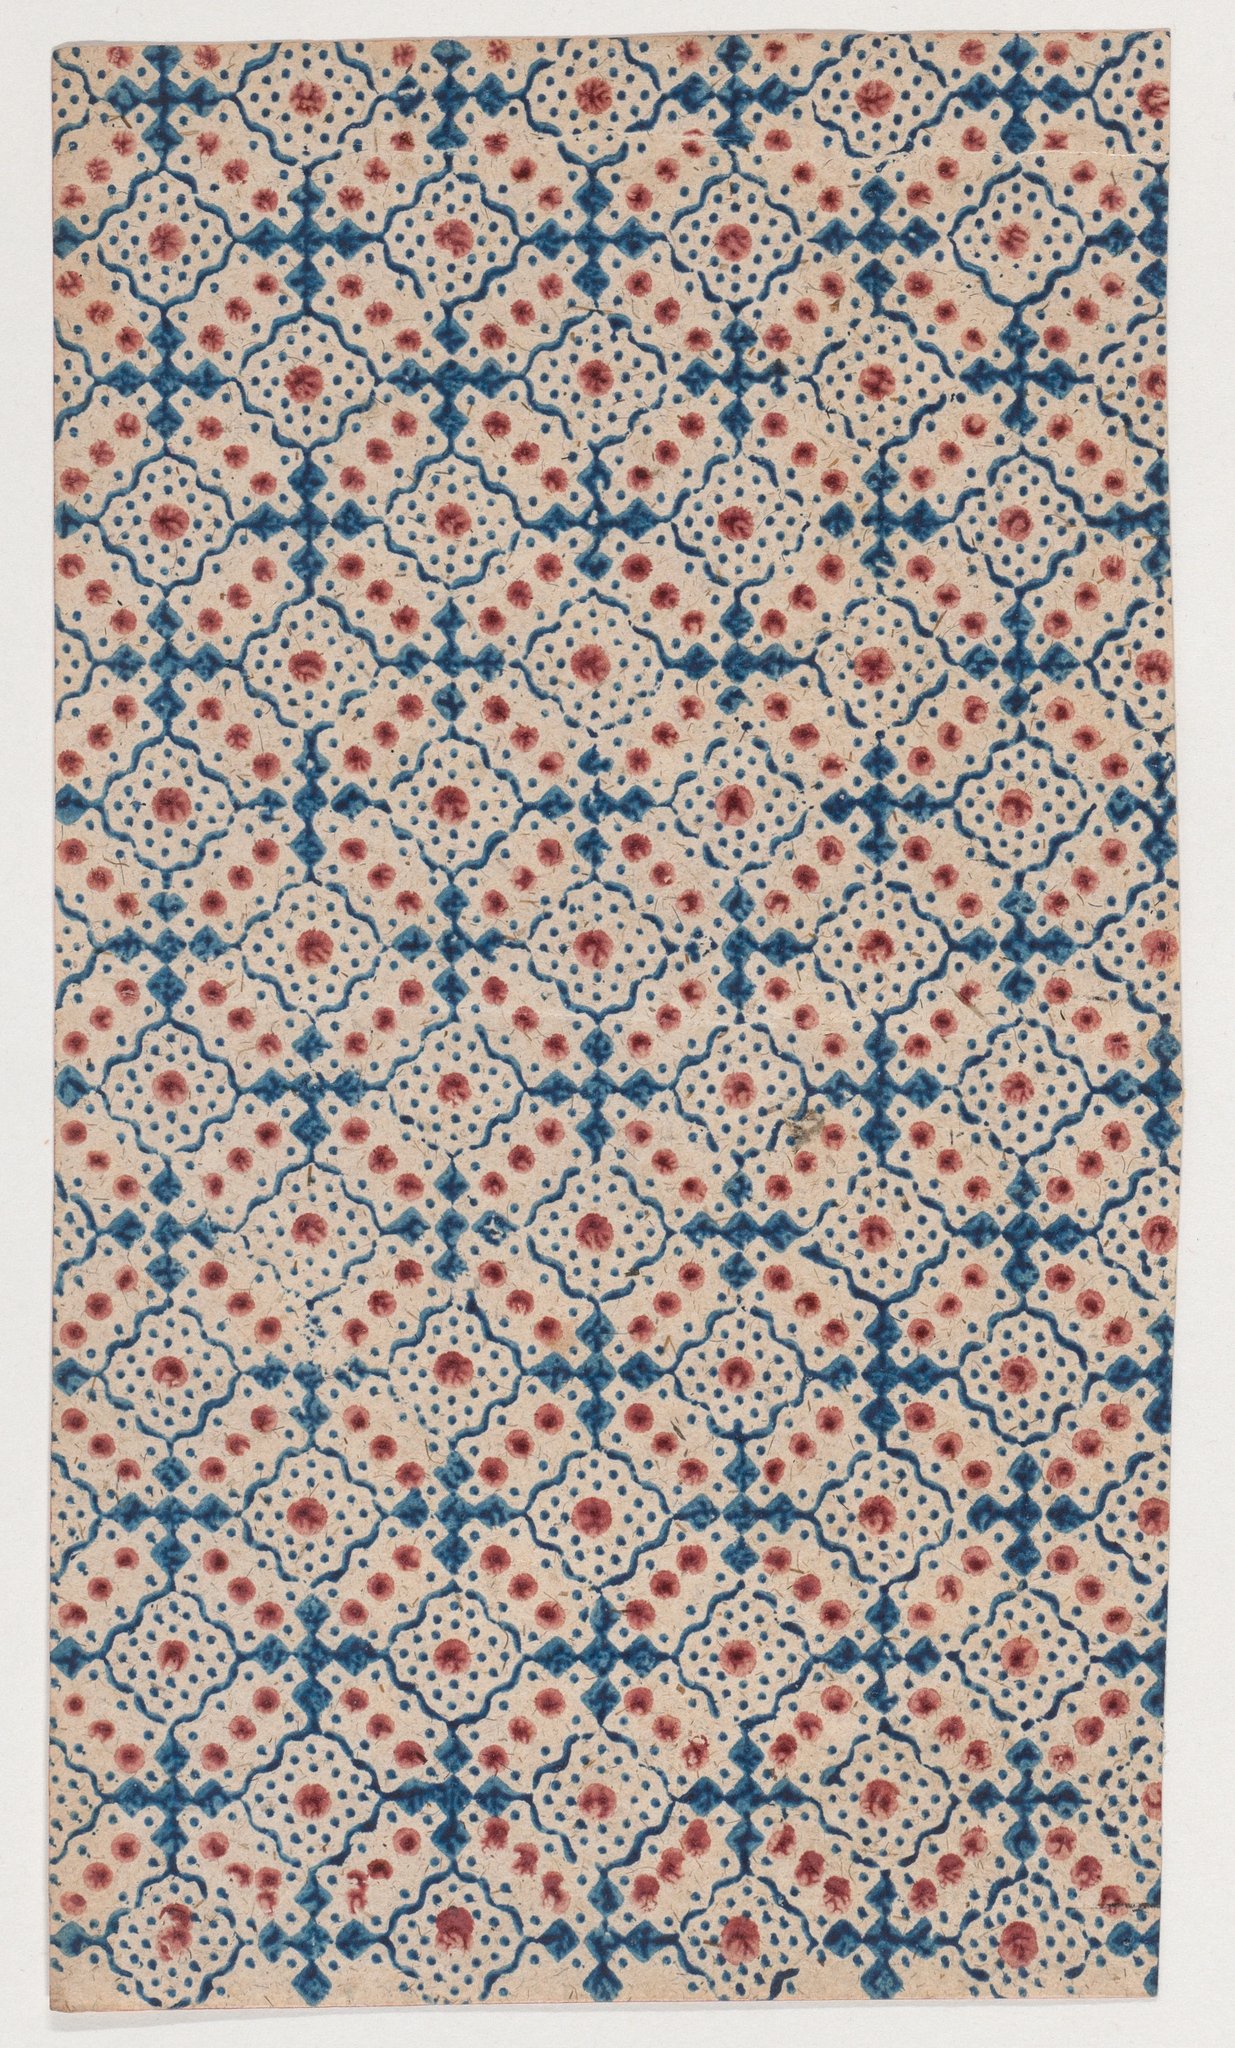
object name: print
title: Sheet with an overall pattern of dots and squares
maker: Anonymous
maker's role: artist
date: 1801-1900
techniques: relief print